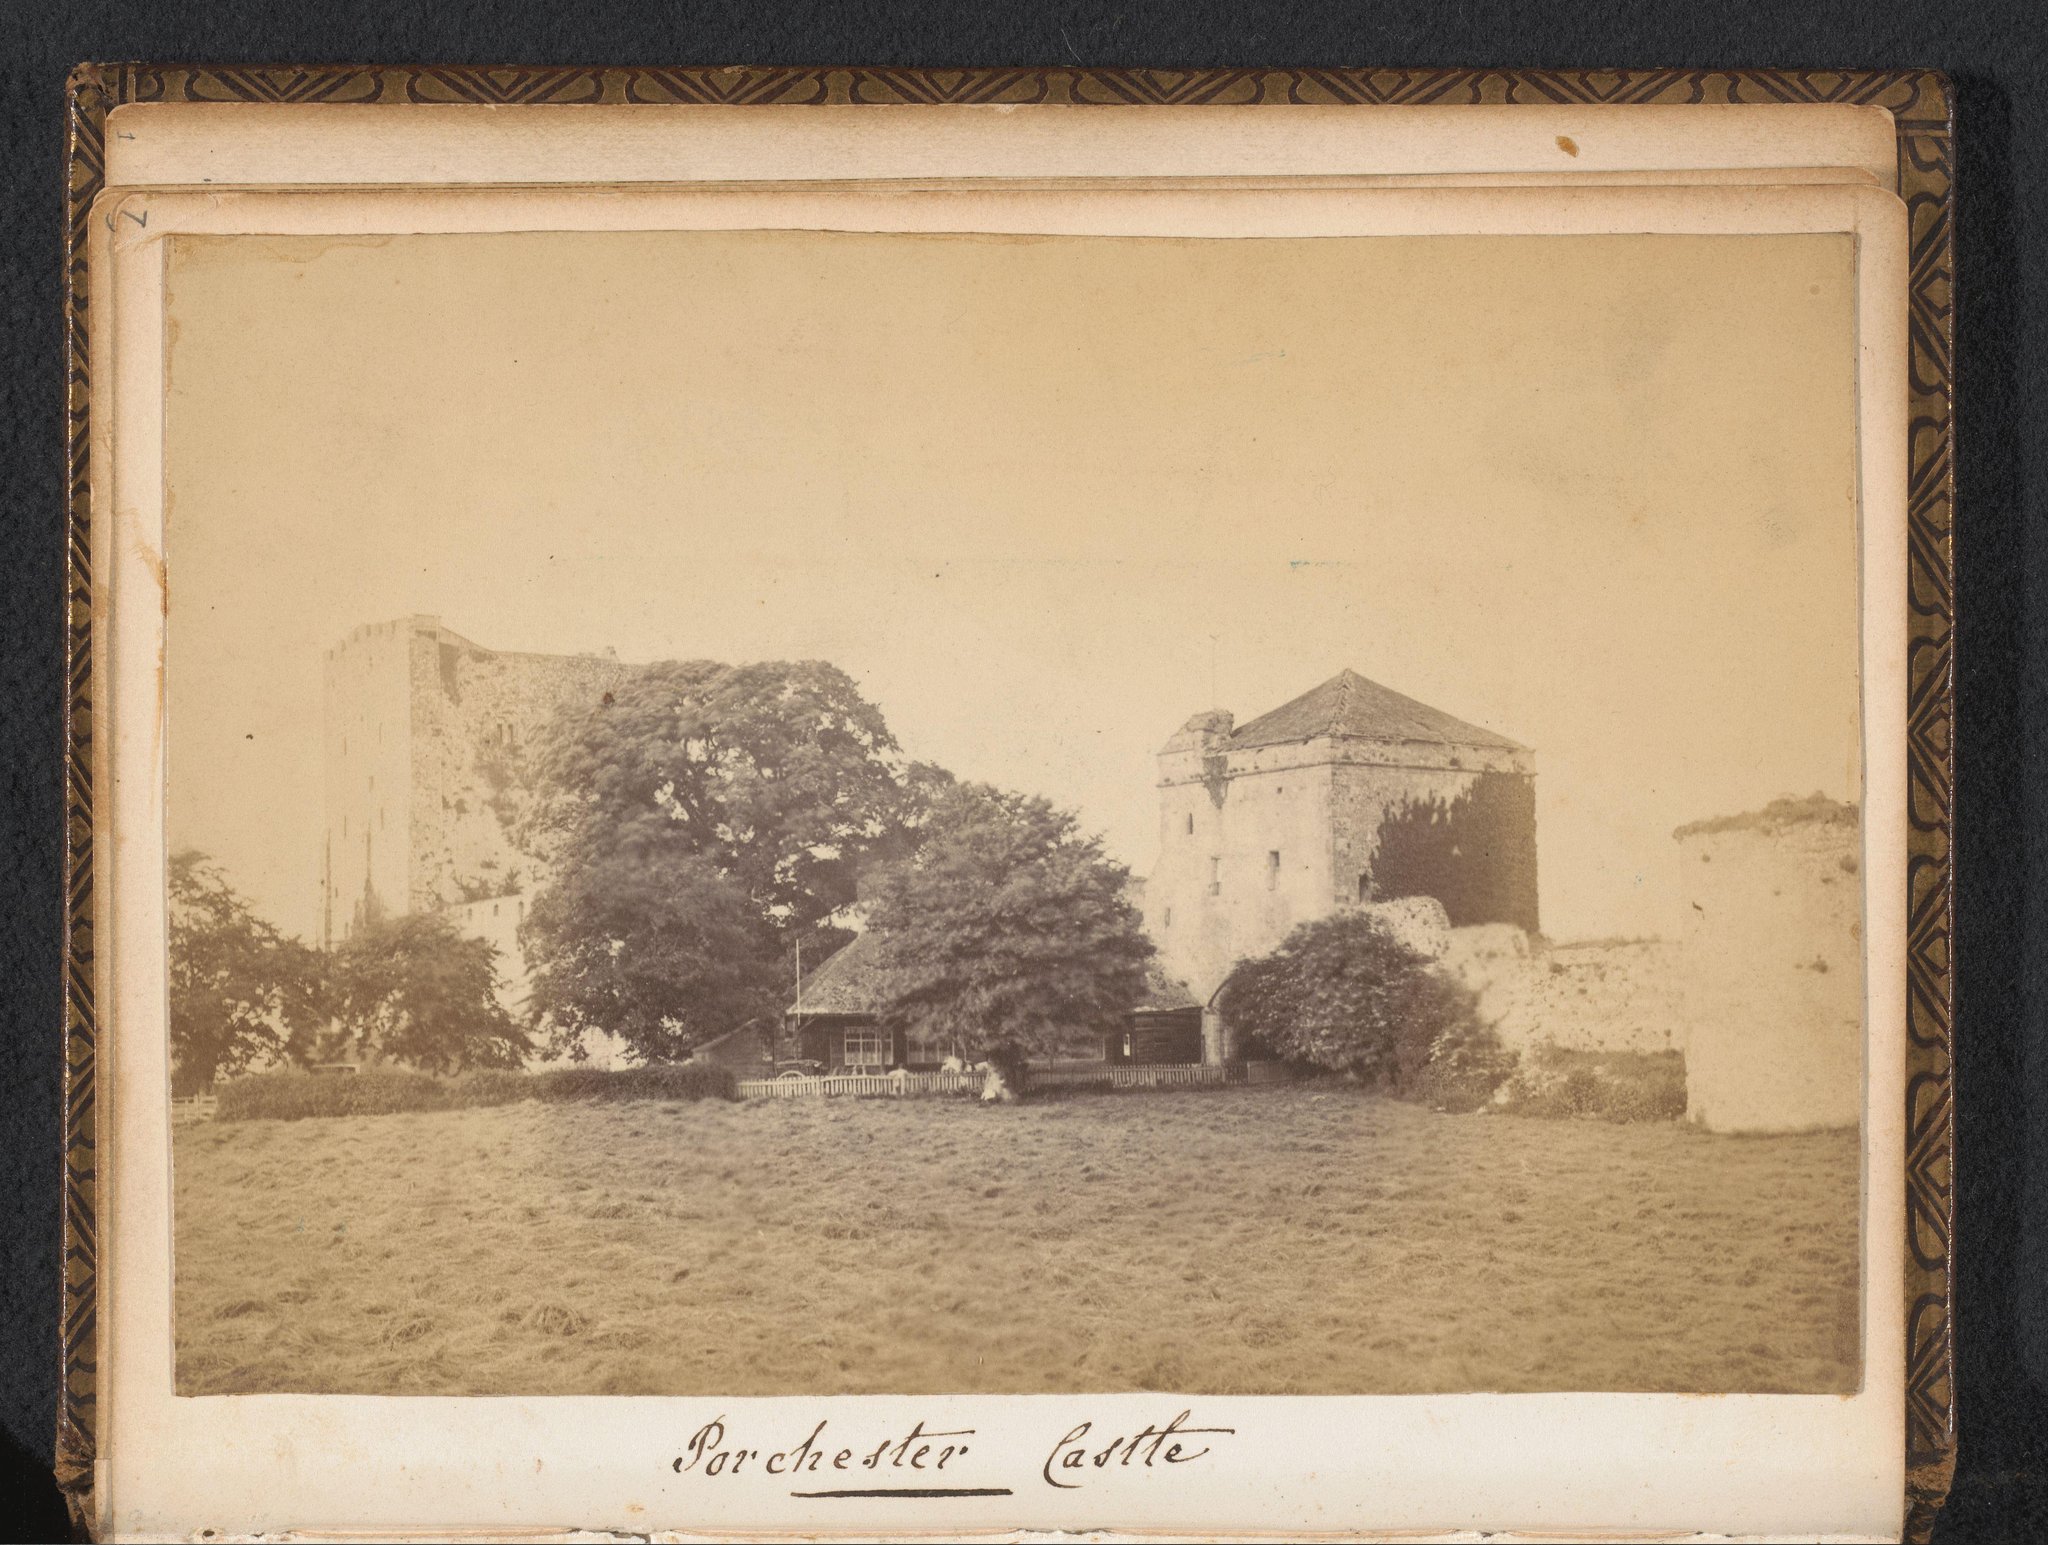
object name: album leaf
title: Portchester Castle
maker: Anonymous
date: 1865-1867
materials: cardboard, photographic support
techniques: albumen print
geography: england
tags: castle, ruin of a dwelling, house, castle, etc.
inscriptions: annotation: ‘Porchester Castle’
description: Portchester Castle. Foto op albumblad in album met 68 foto's merendeels met geaquarelleerde randversieringen. Het zijn voornamelijk portretten op carte-de-visite formaat.